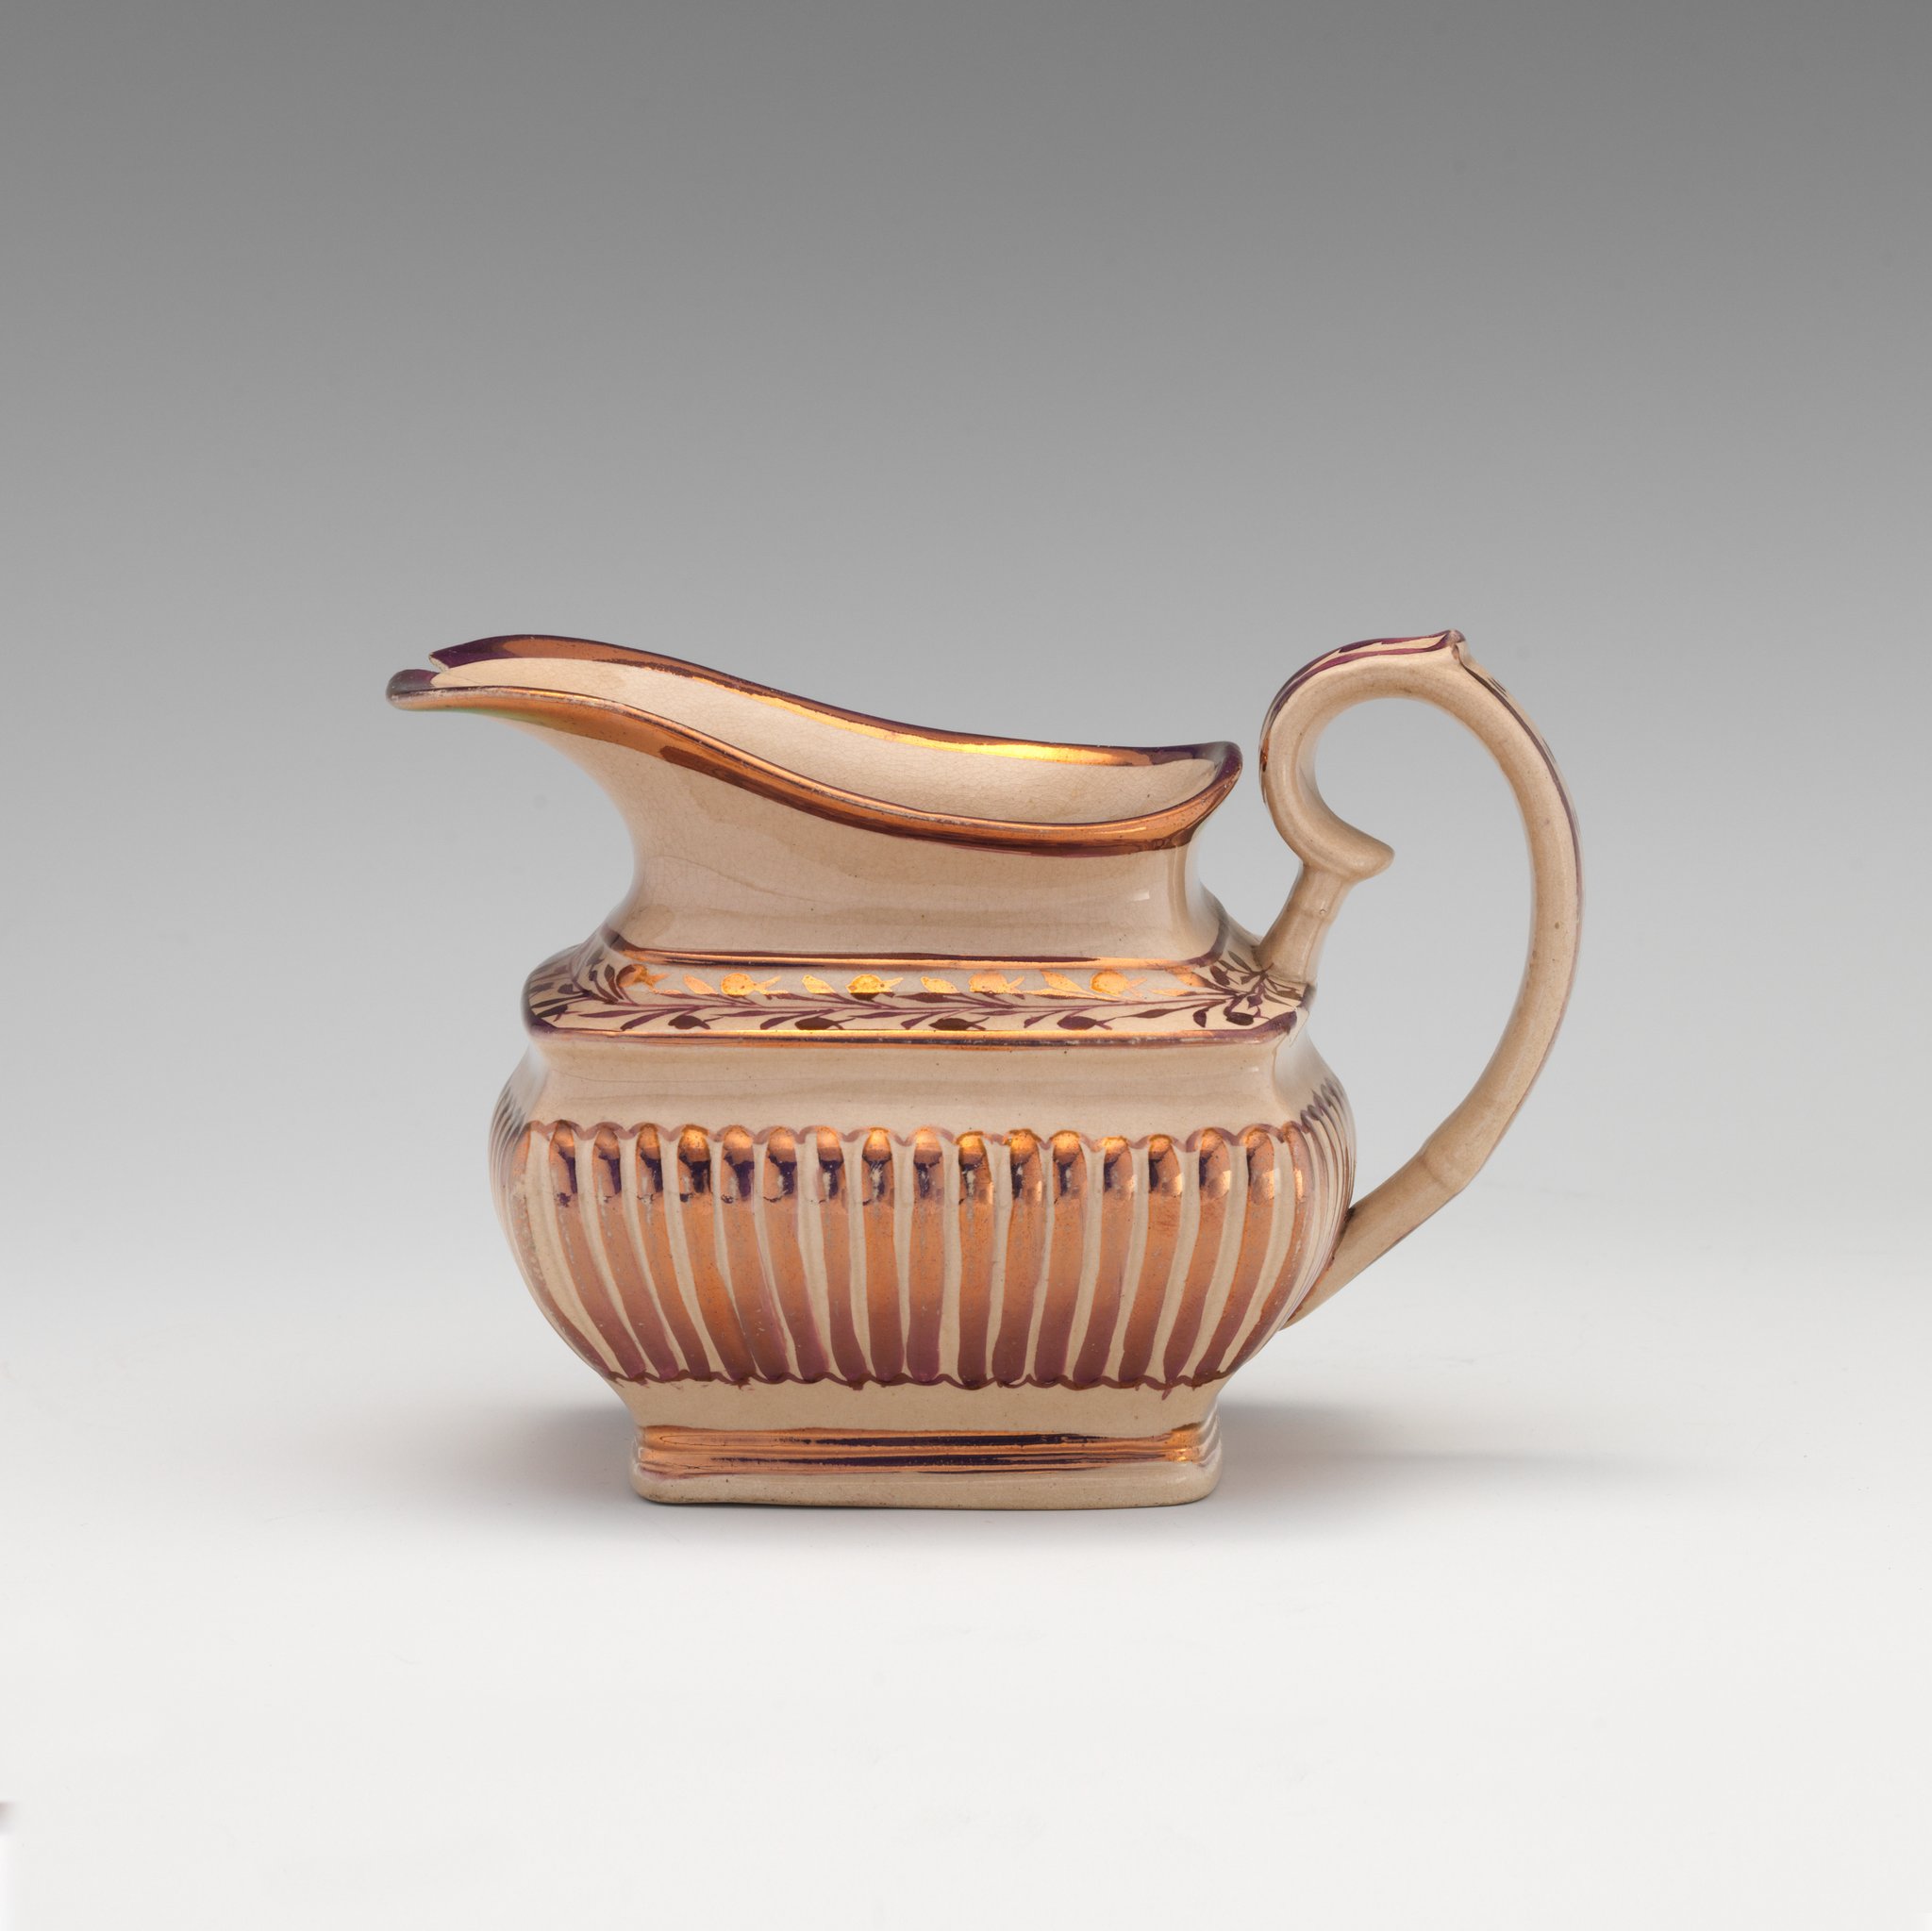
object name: cream jug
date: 1801-1833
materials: earthenware